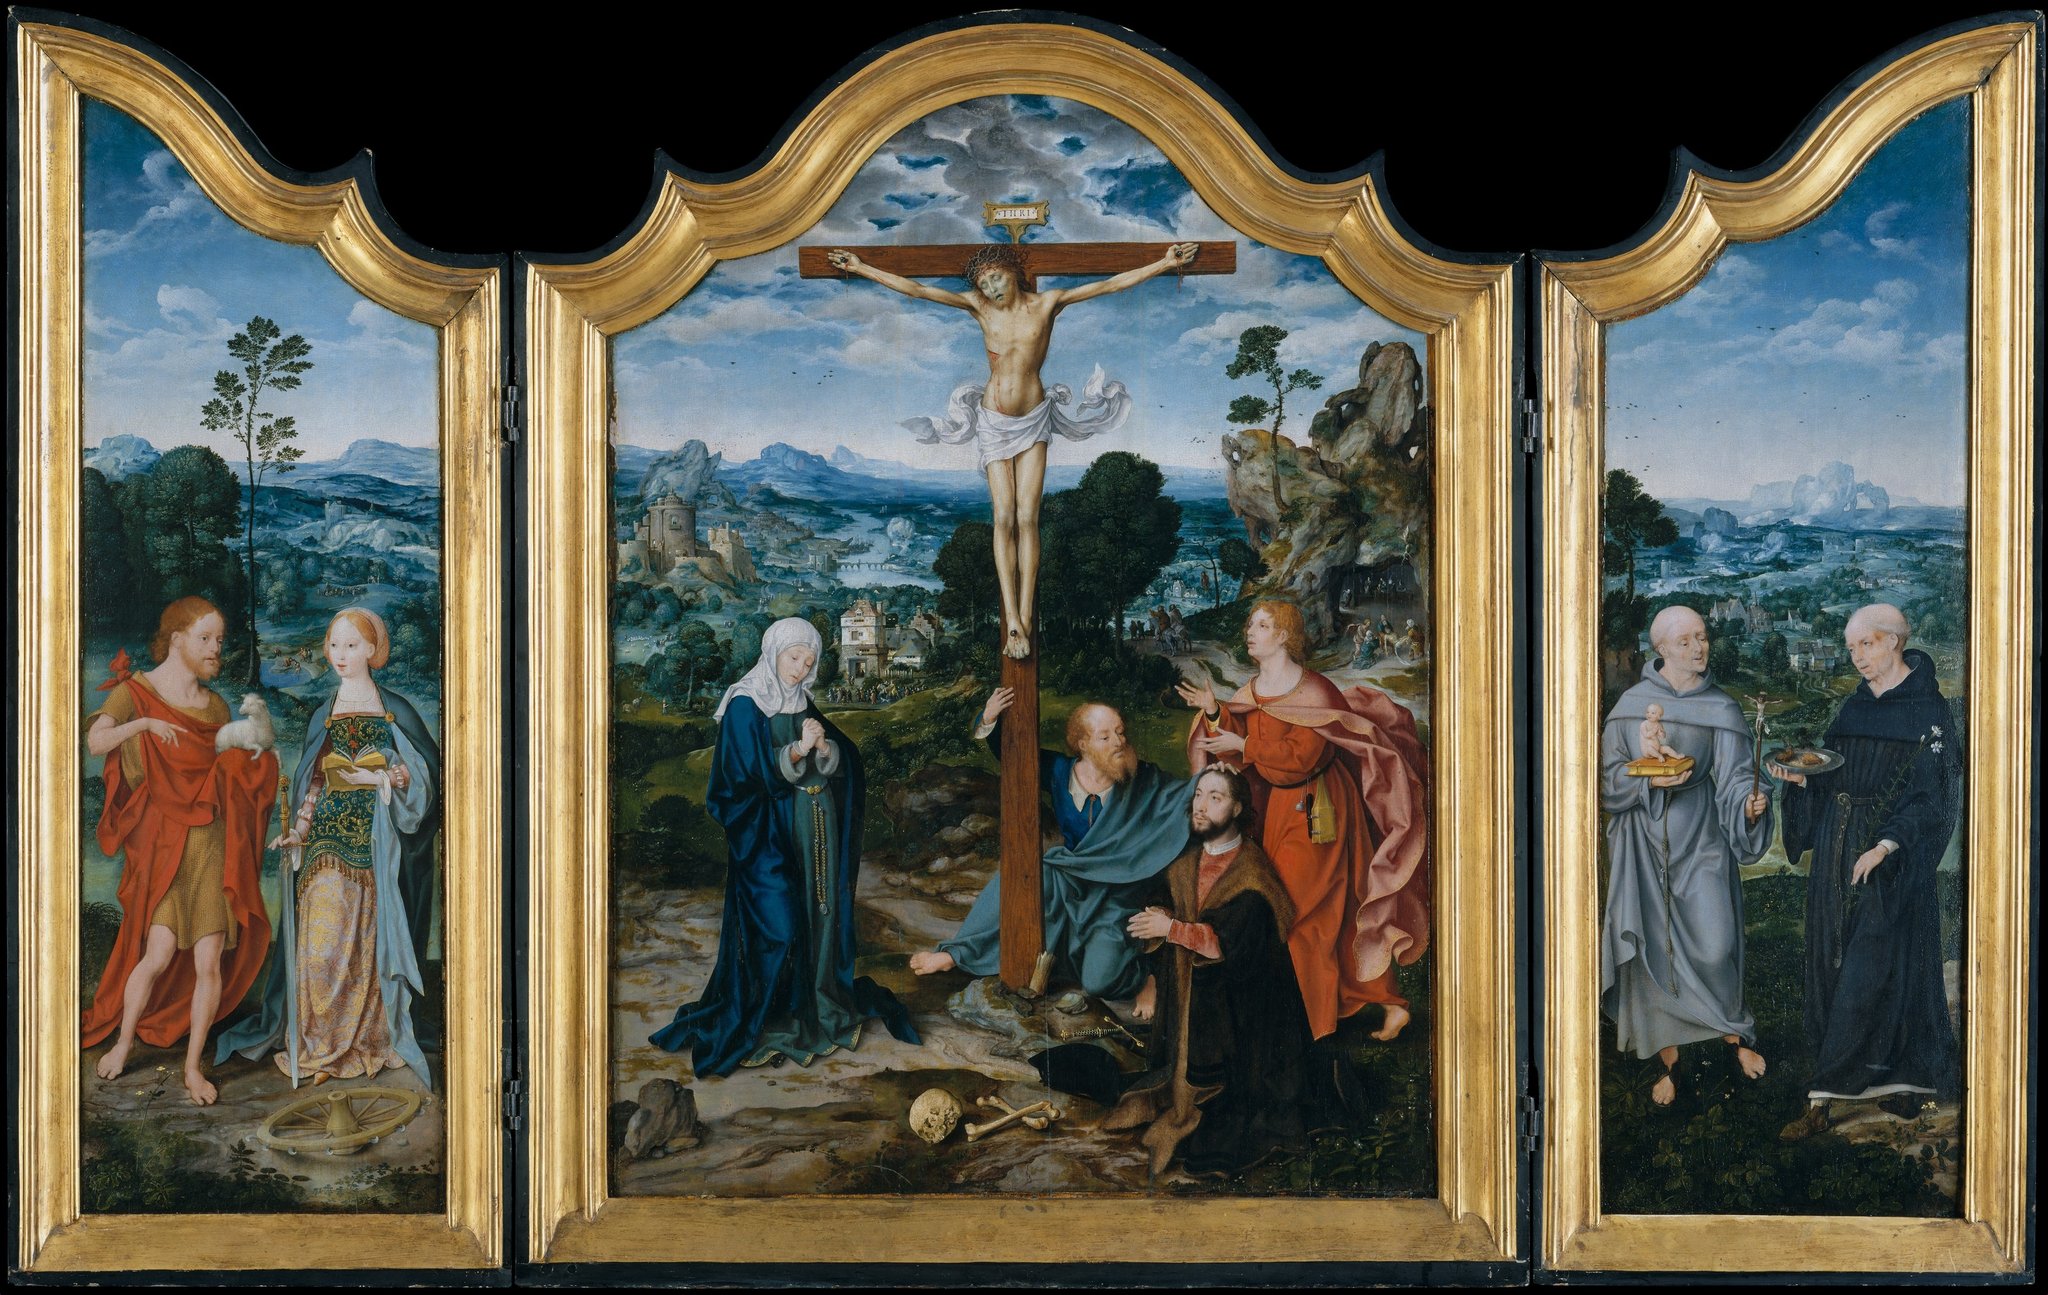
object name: painting, triptych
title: The Crucifixion with Saints and a Donor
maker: joos van cleve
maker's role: artist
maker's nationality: netherlandish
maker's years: 1485-1541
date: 1520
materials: oil, wood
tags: skulls,men,christ,virgin mary,crucifixion,saints